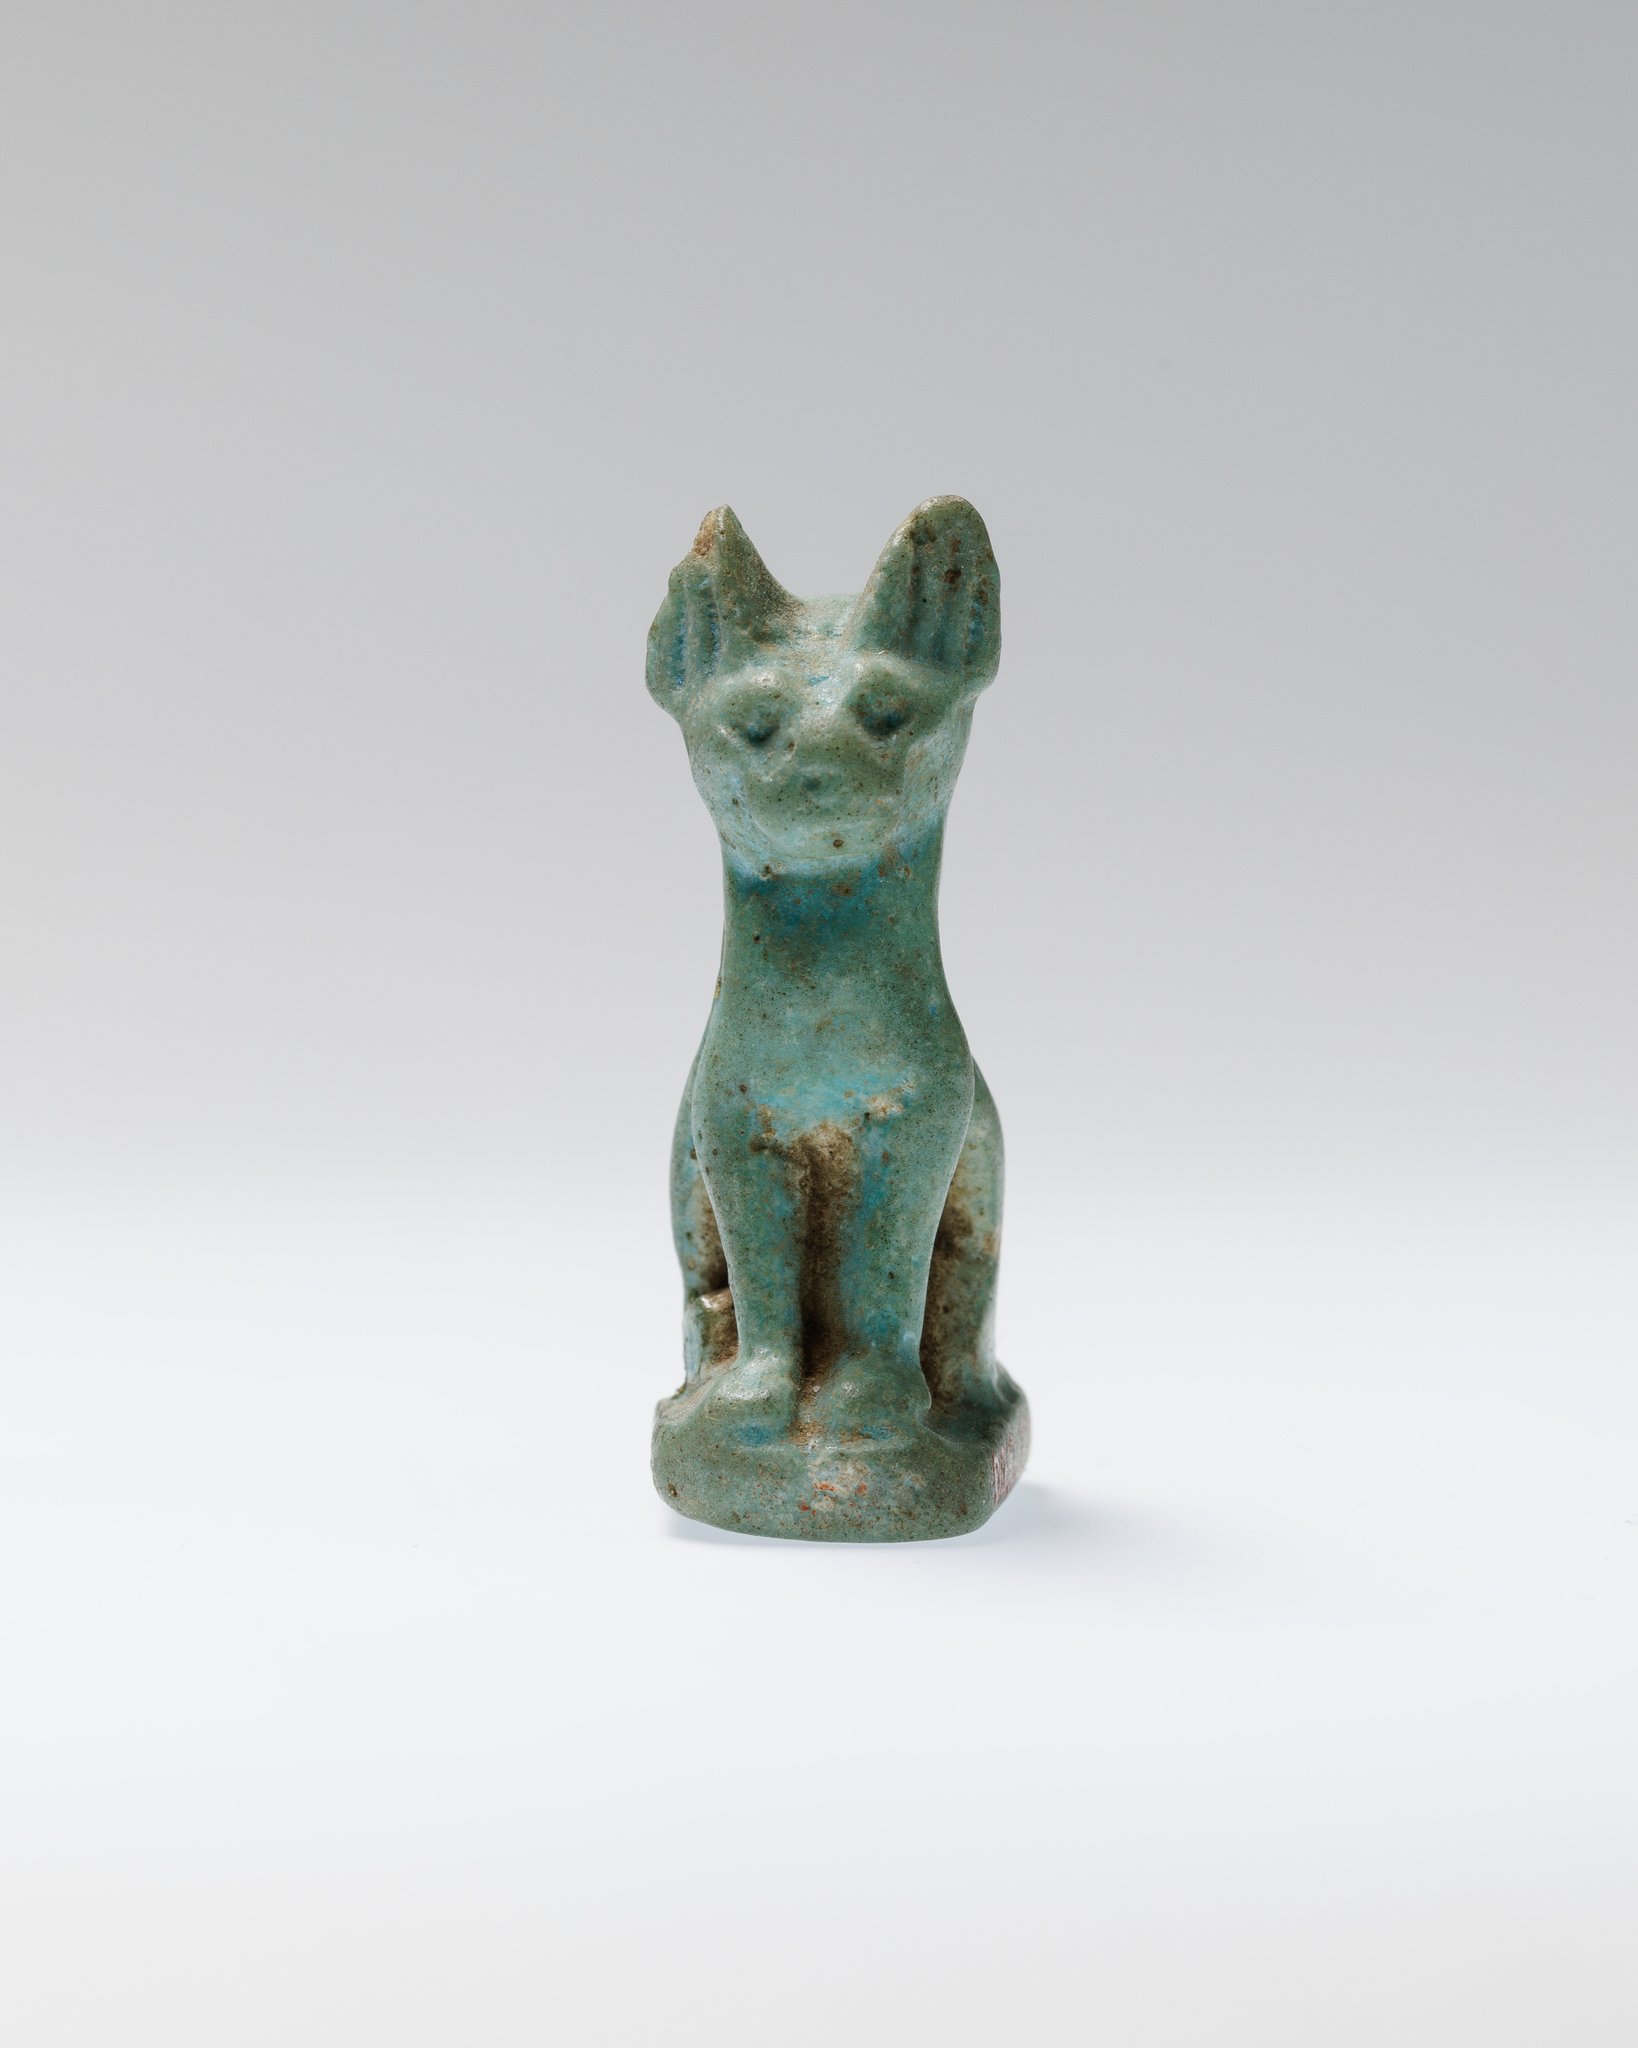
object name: amulet, cat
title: Cat Amulet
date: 664-332 BCE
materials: faience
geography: egypt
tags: cats